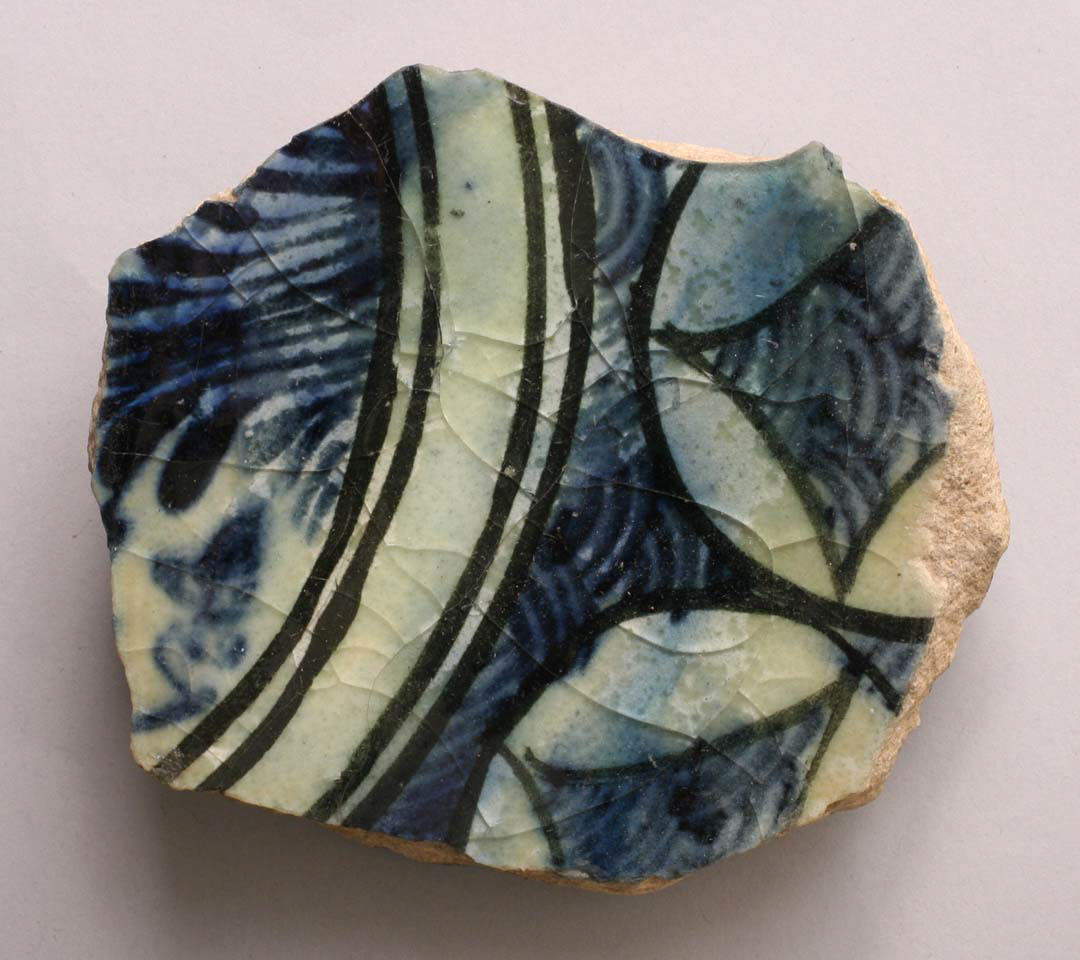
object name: fragment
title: Ceramic Fragment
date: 1301-1500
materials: glaze, stonepaste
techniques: painting, polychrome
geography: egypt